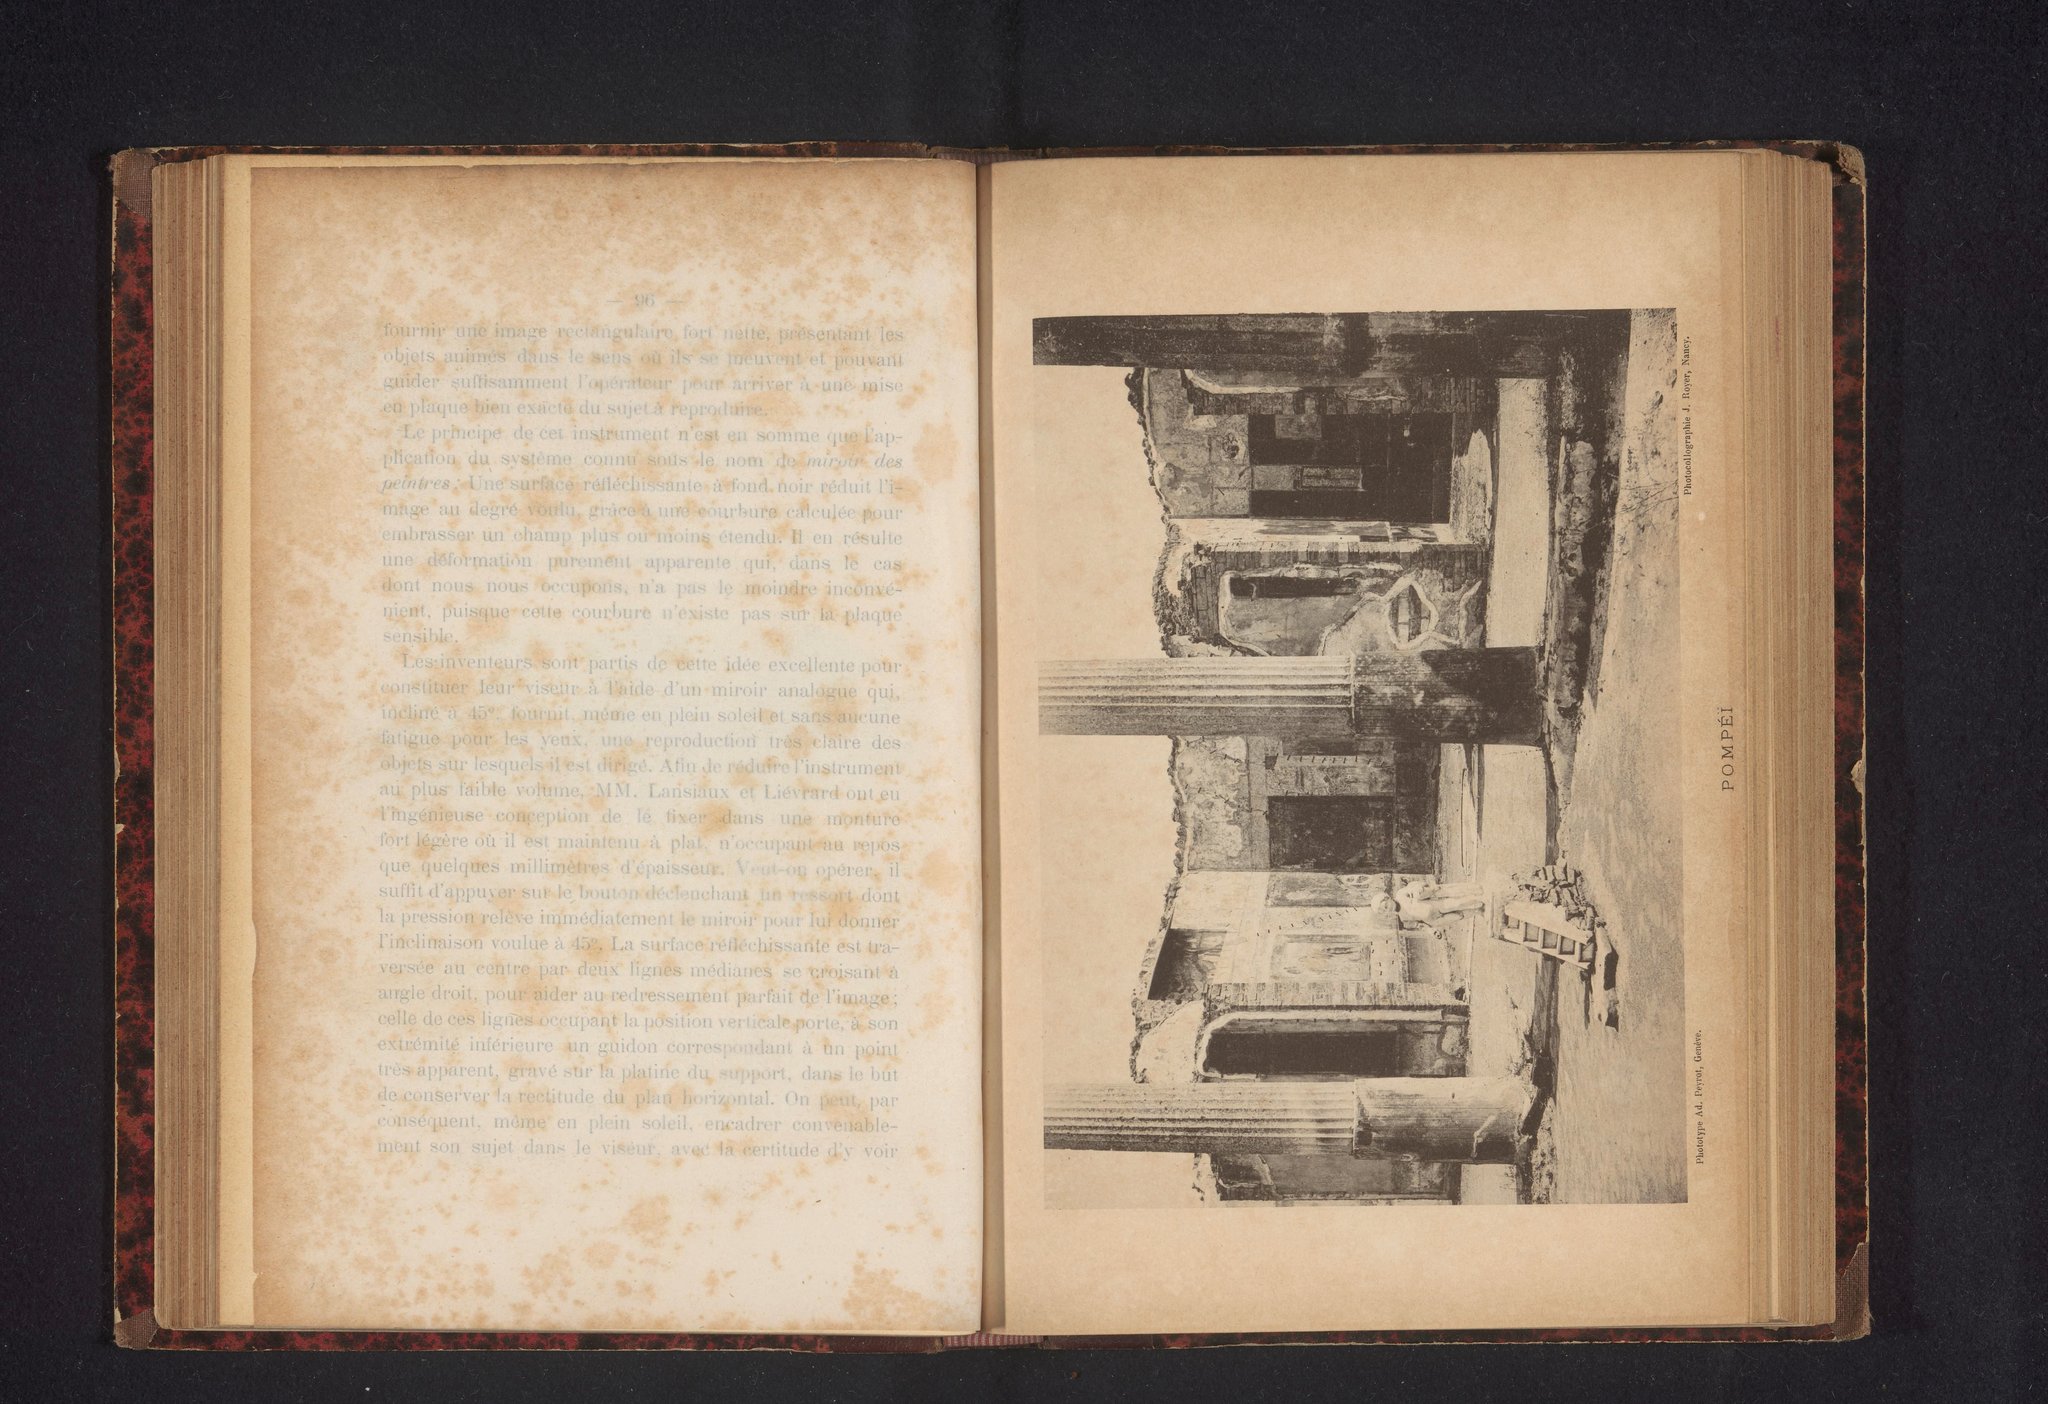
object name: photomechanical print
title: Pompéï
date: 1889-1894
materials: paper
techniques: photograph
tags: column, pillar ~ architecture, ruin of a building ~ architecture, pompeii